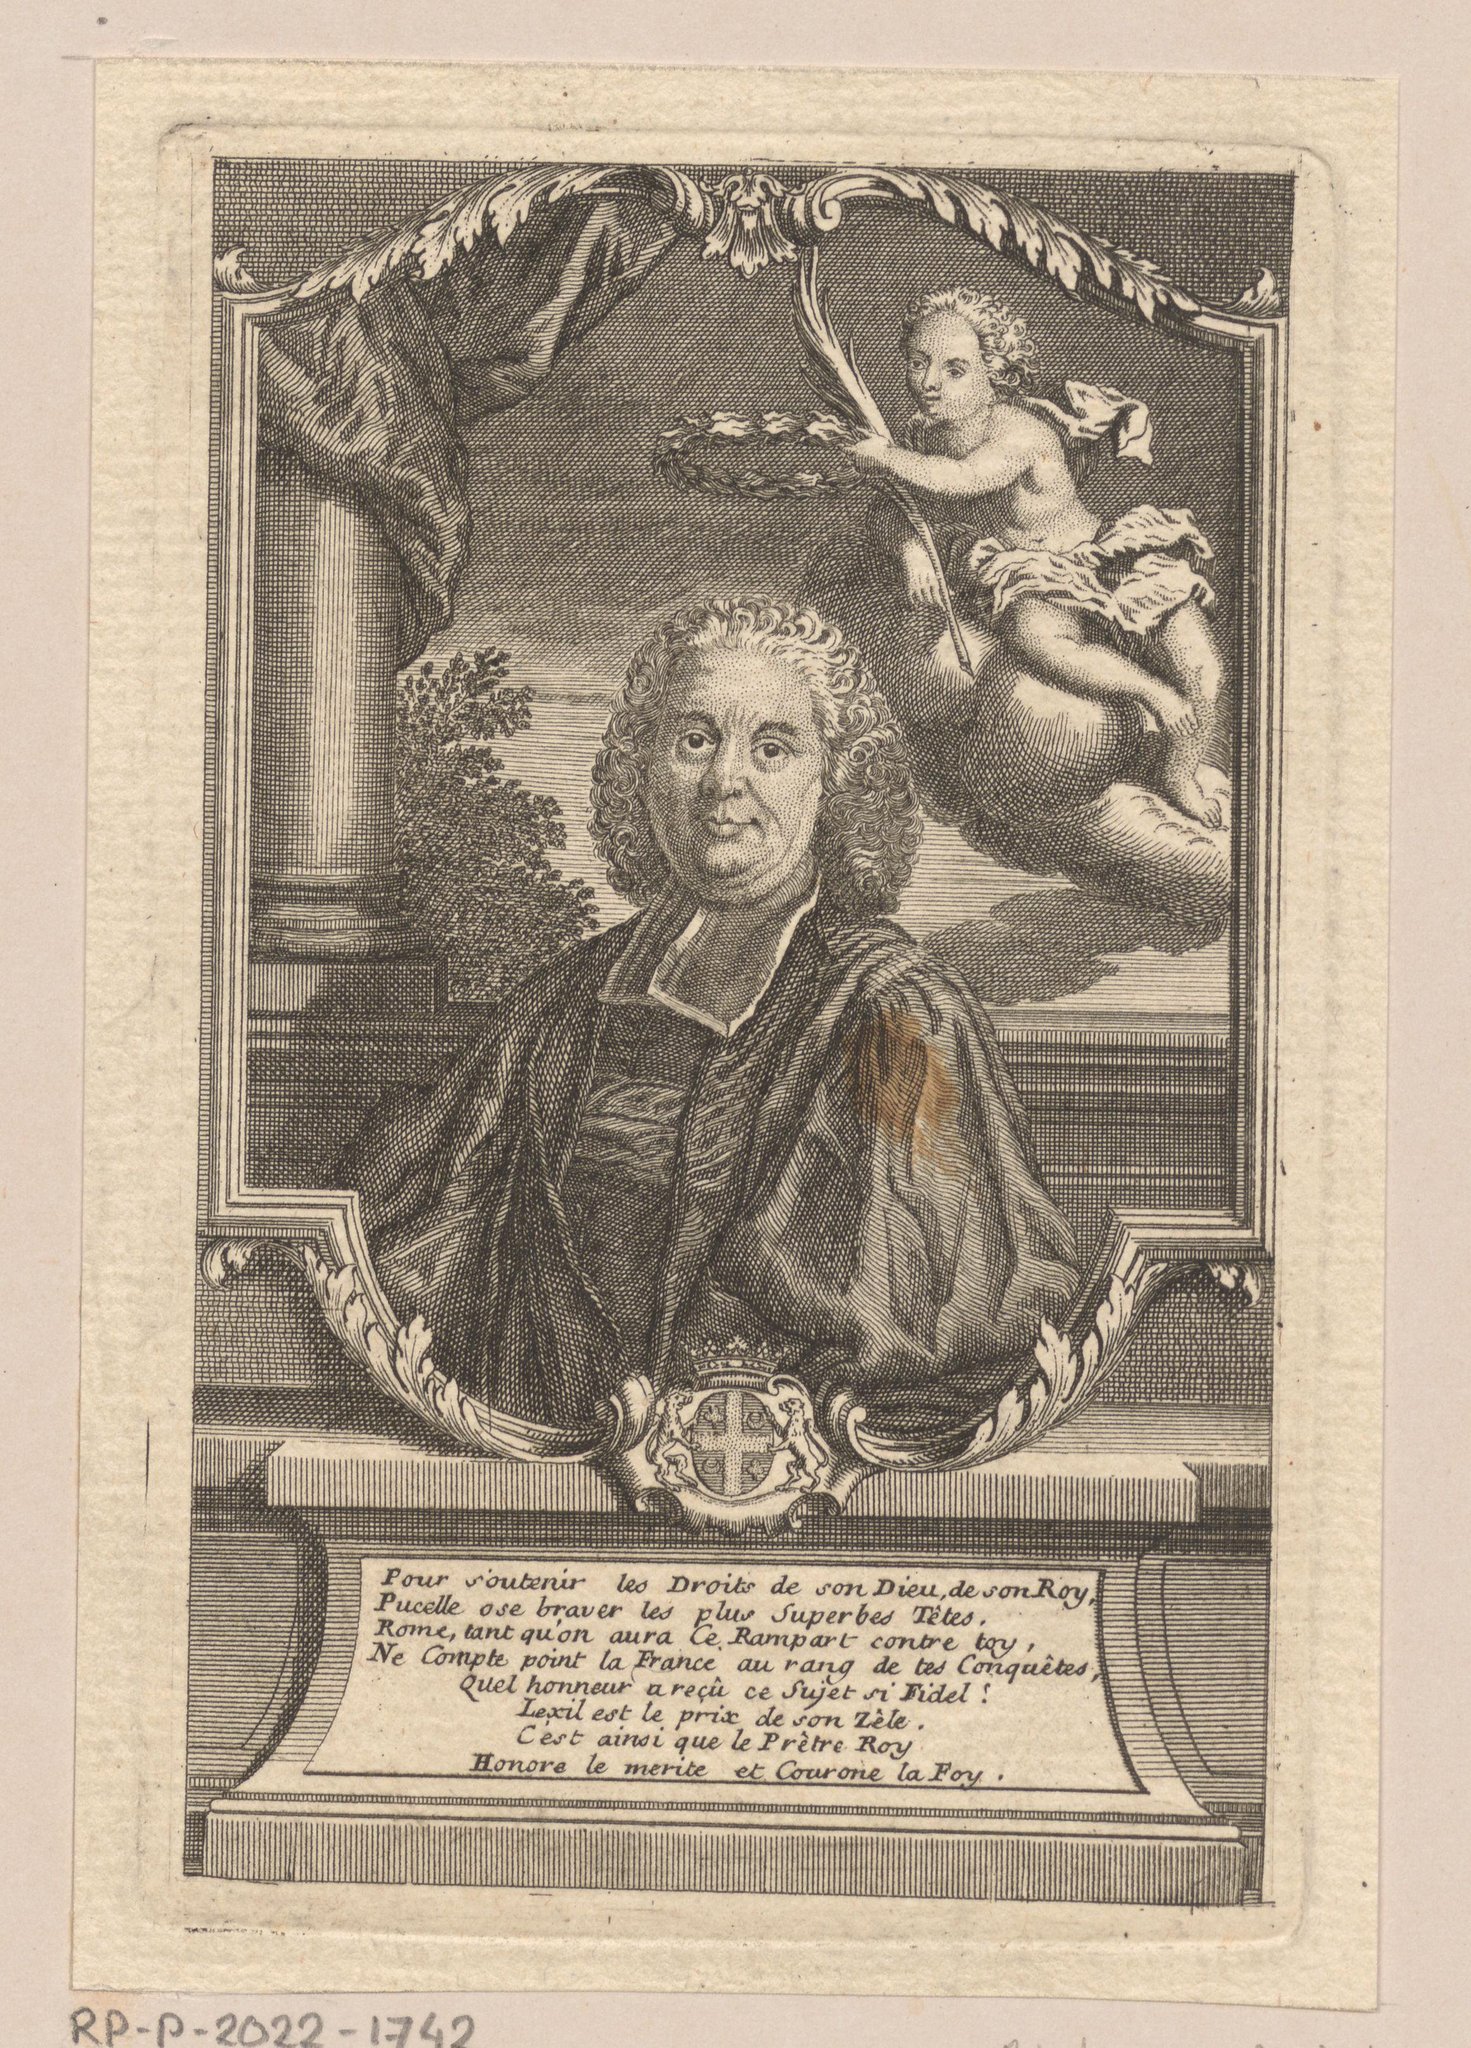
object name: print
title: Portret van René Pucelle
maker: Anonymous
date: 1721-1750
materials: paper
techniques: etching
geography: france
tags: paris, historical persons, magistracy, judges, crowning with laurel, cupids: 'amores', 'amoretti', 'putti'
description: Met zevenregelig onderschrift in het Frans.